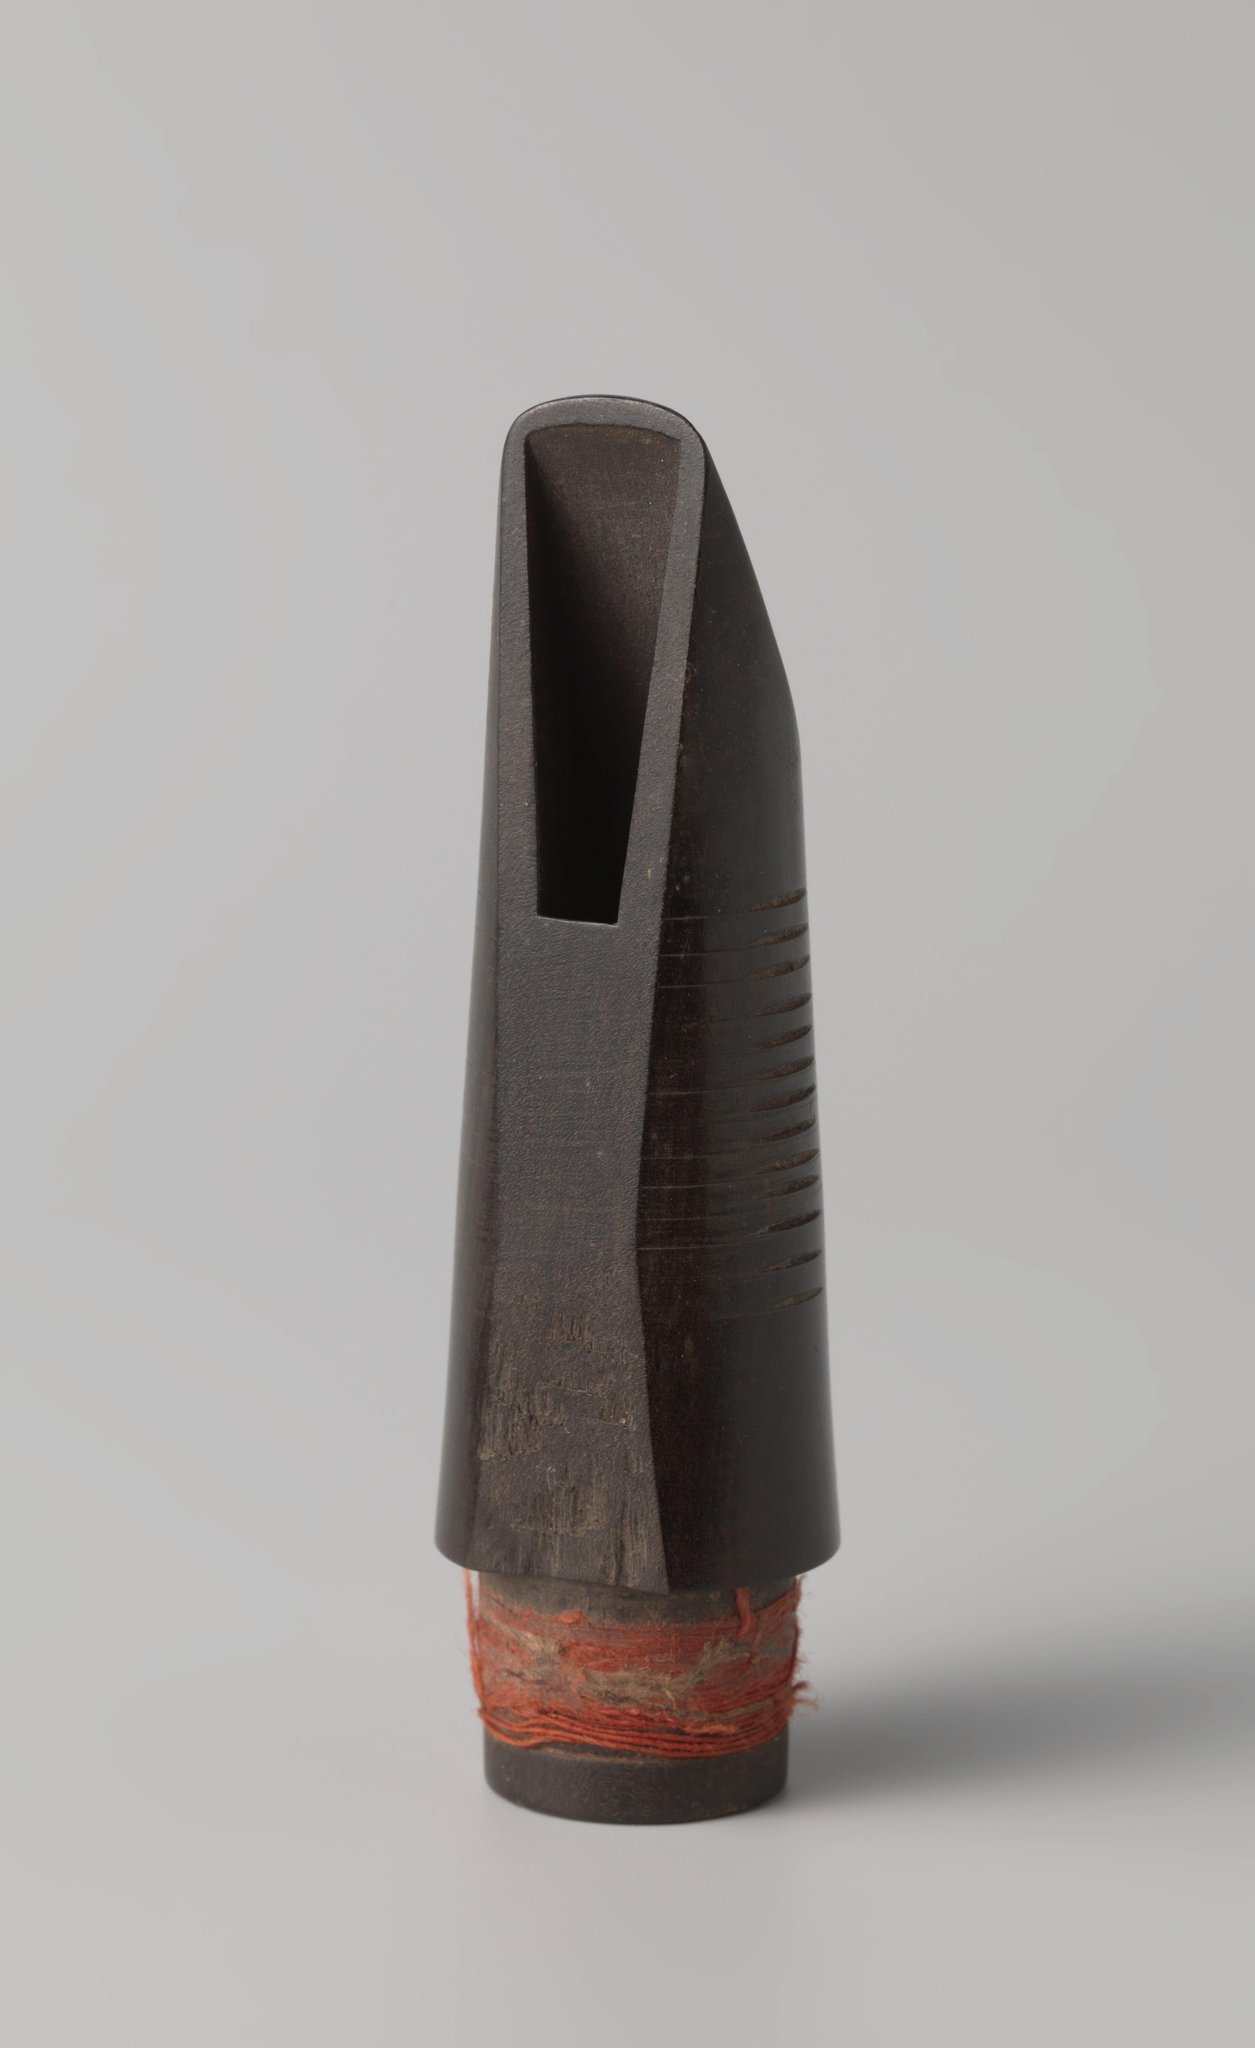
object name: element of musical instrument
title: Clarinet mouthpiece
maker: Anonymous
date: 1840-1860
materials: wood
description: Mondstuk van een klarinet, vervaardigd van rozenhout